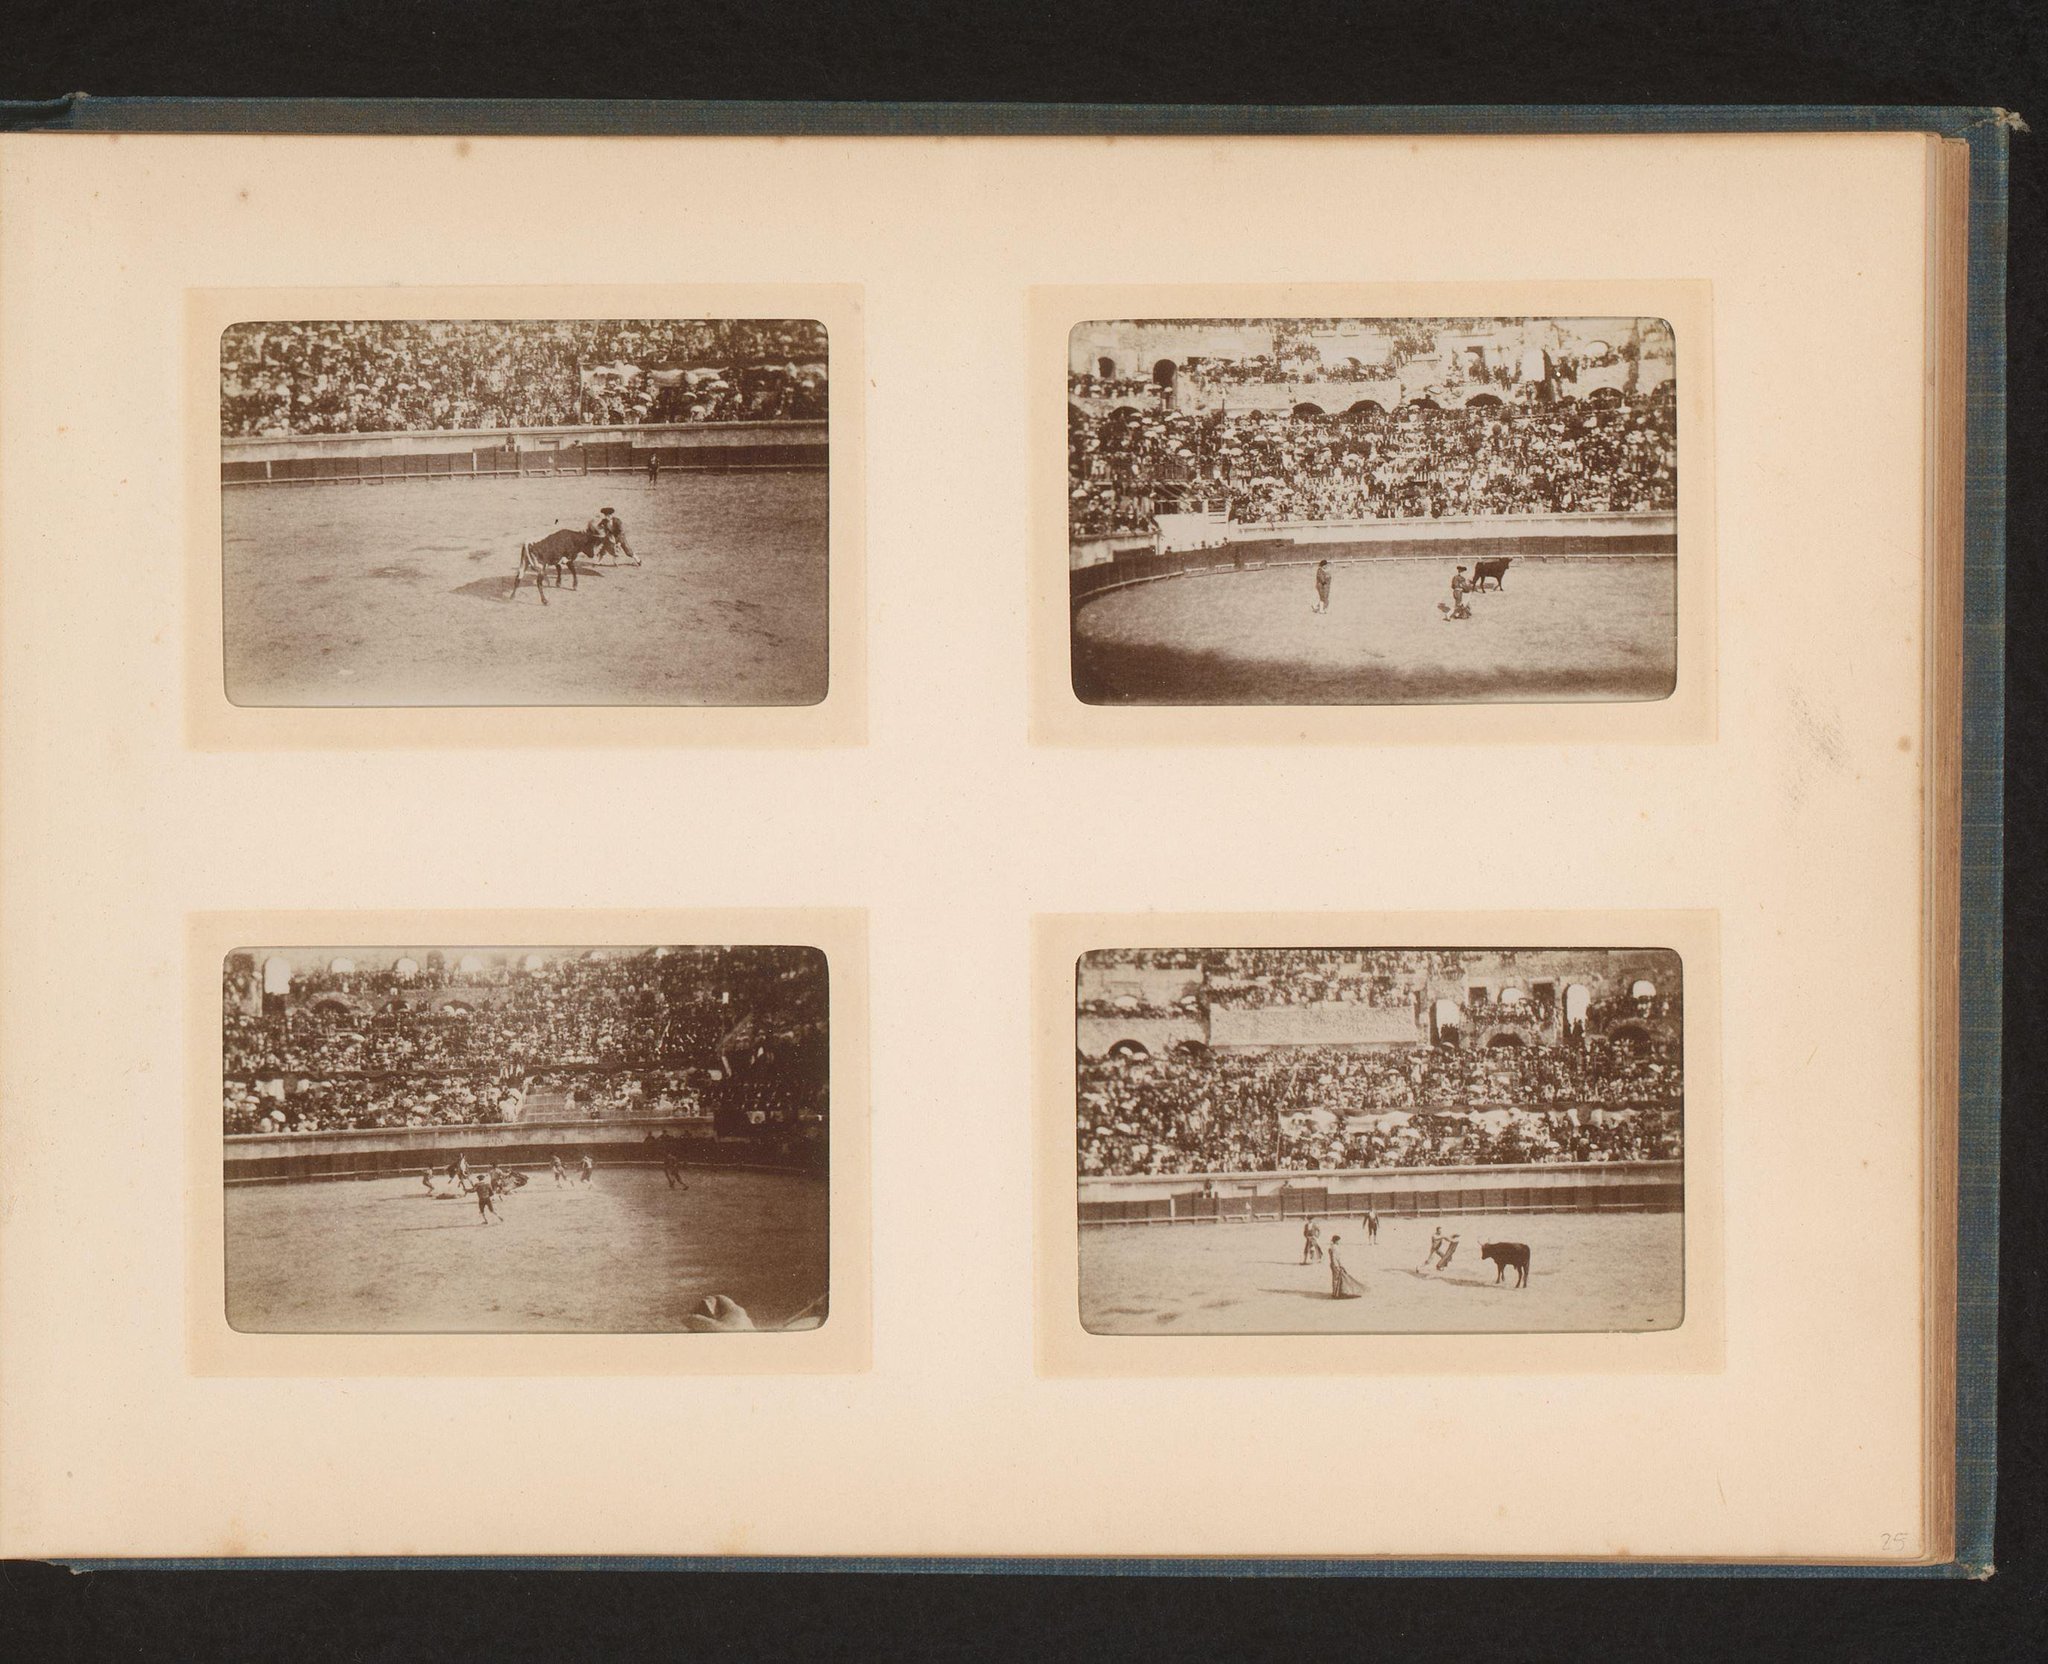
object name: photograph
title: Vier opnamen van stierengevechten in het amfitheater te Arles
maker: Anonymous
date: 1900-1915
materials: paper, photographic support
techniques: gelatin silver print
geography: france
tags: bullfight, amphitheatre, travelling; tourism, france